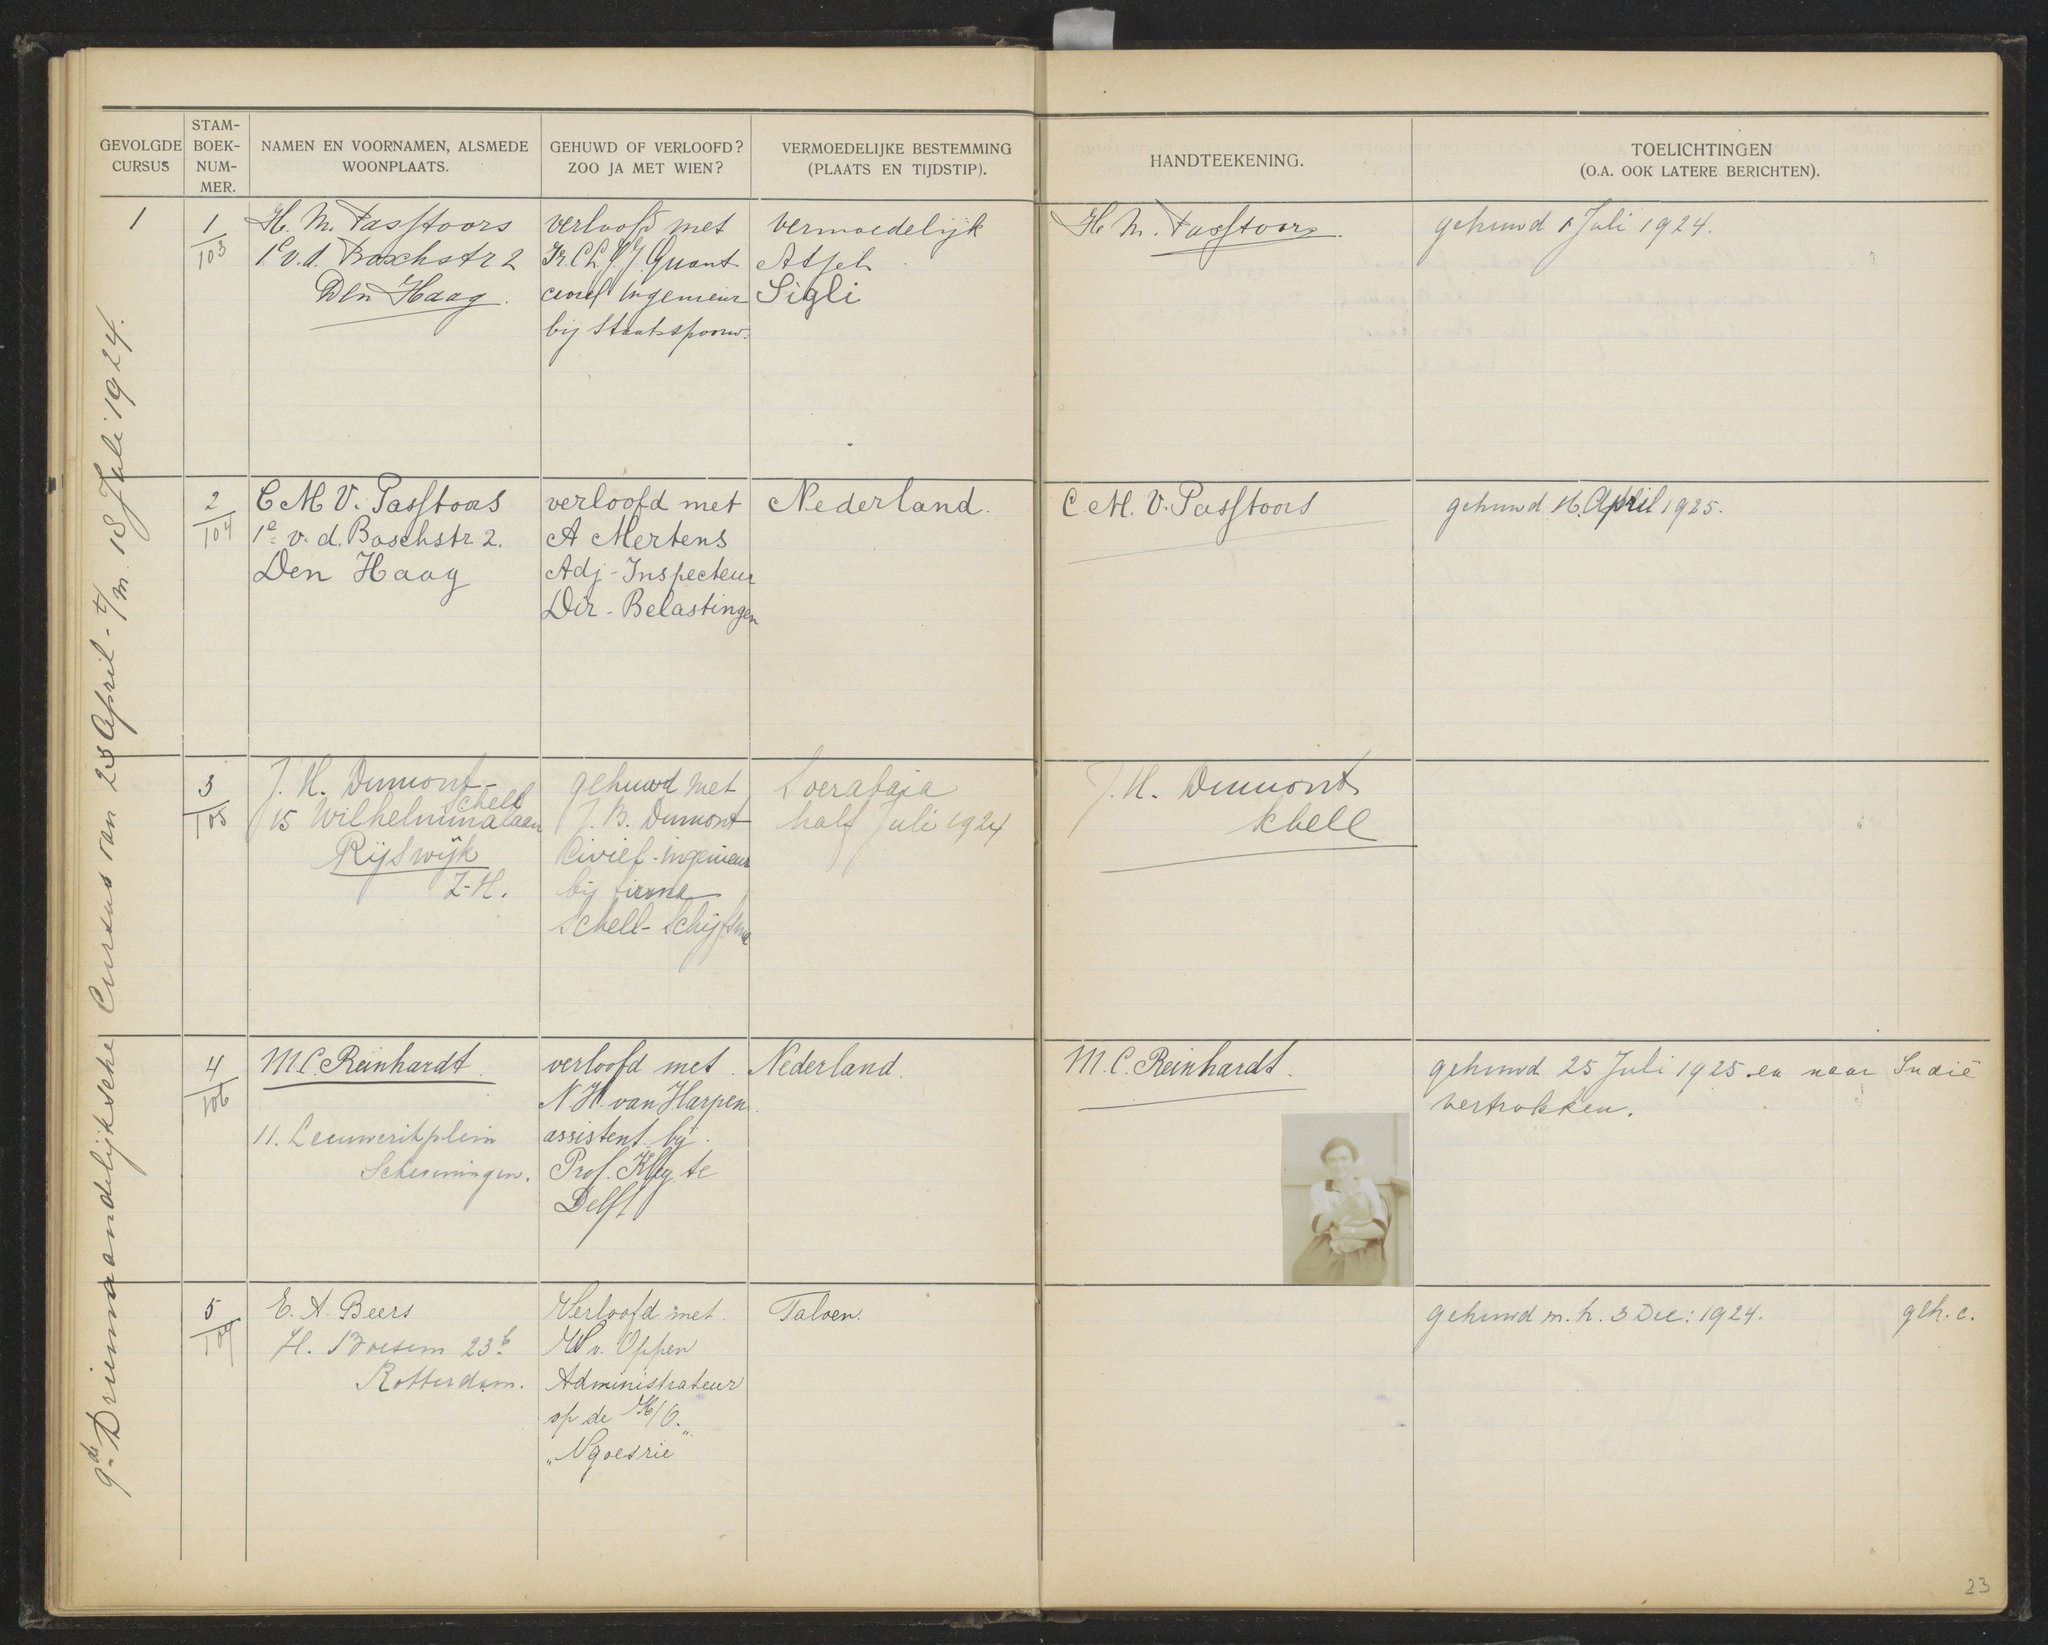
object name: photograph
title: Blad 23 uit Stamboek van de leerlingen der Koloniale School voor Meisjes en Vrouwen te 's-Gravenhage deel I (1921-1929)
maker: Anonymous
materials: paper, photographic support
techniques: photography, printing, writing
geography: the hague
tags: further education (+ pupil), further education, the hague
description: Twee pagina's met gegevens van de deelnemers aan de 9e driemaandelijkse cursus van 23 april tot en met 18 juli 1924, stamboeknummers 103 tot en met 107. Onderdeel van Stamboek van de leerlingen der Koloniale School voor Meisjes en Vrouwen te 's-Gravenhage deel I (1921-1929).